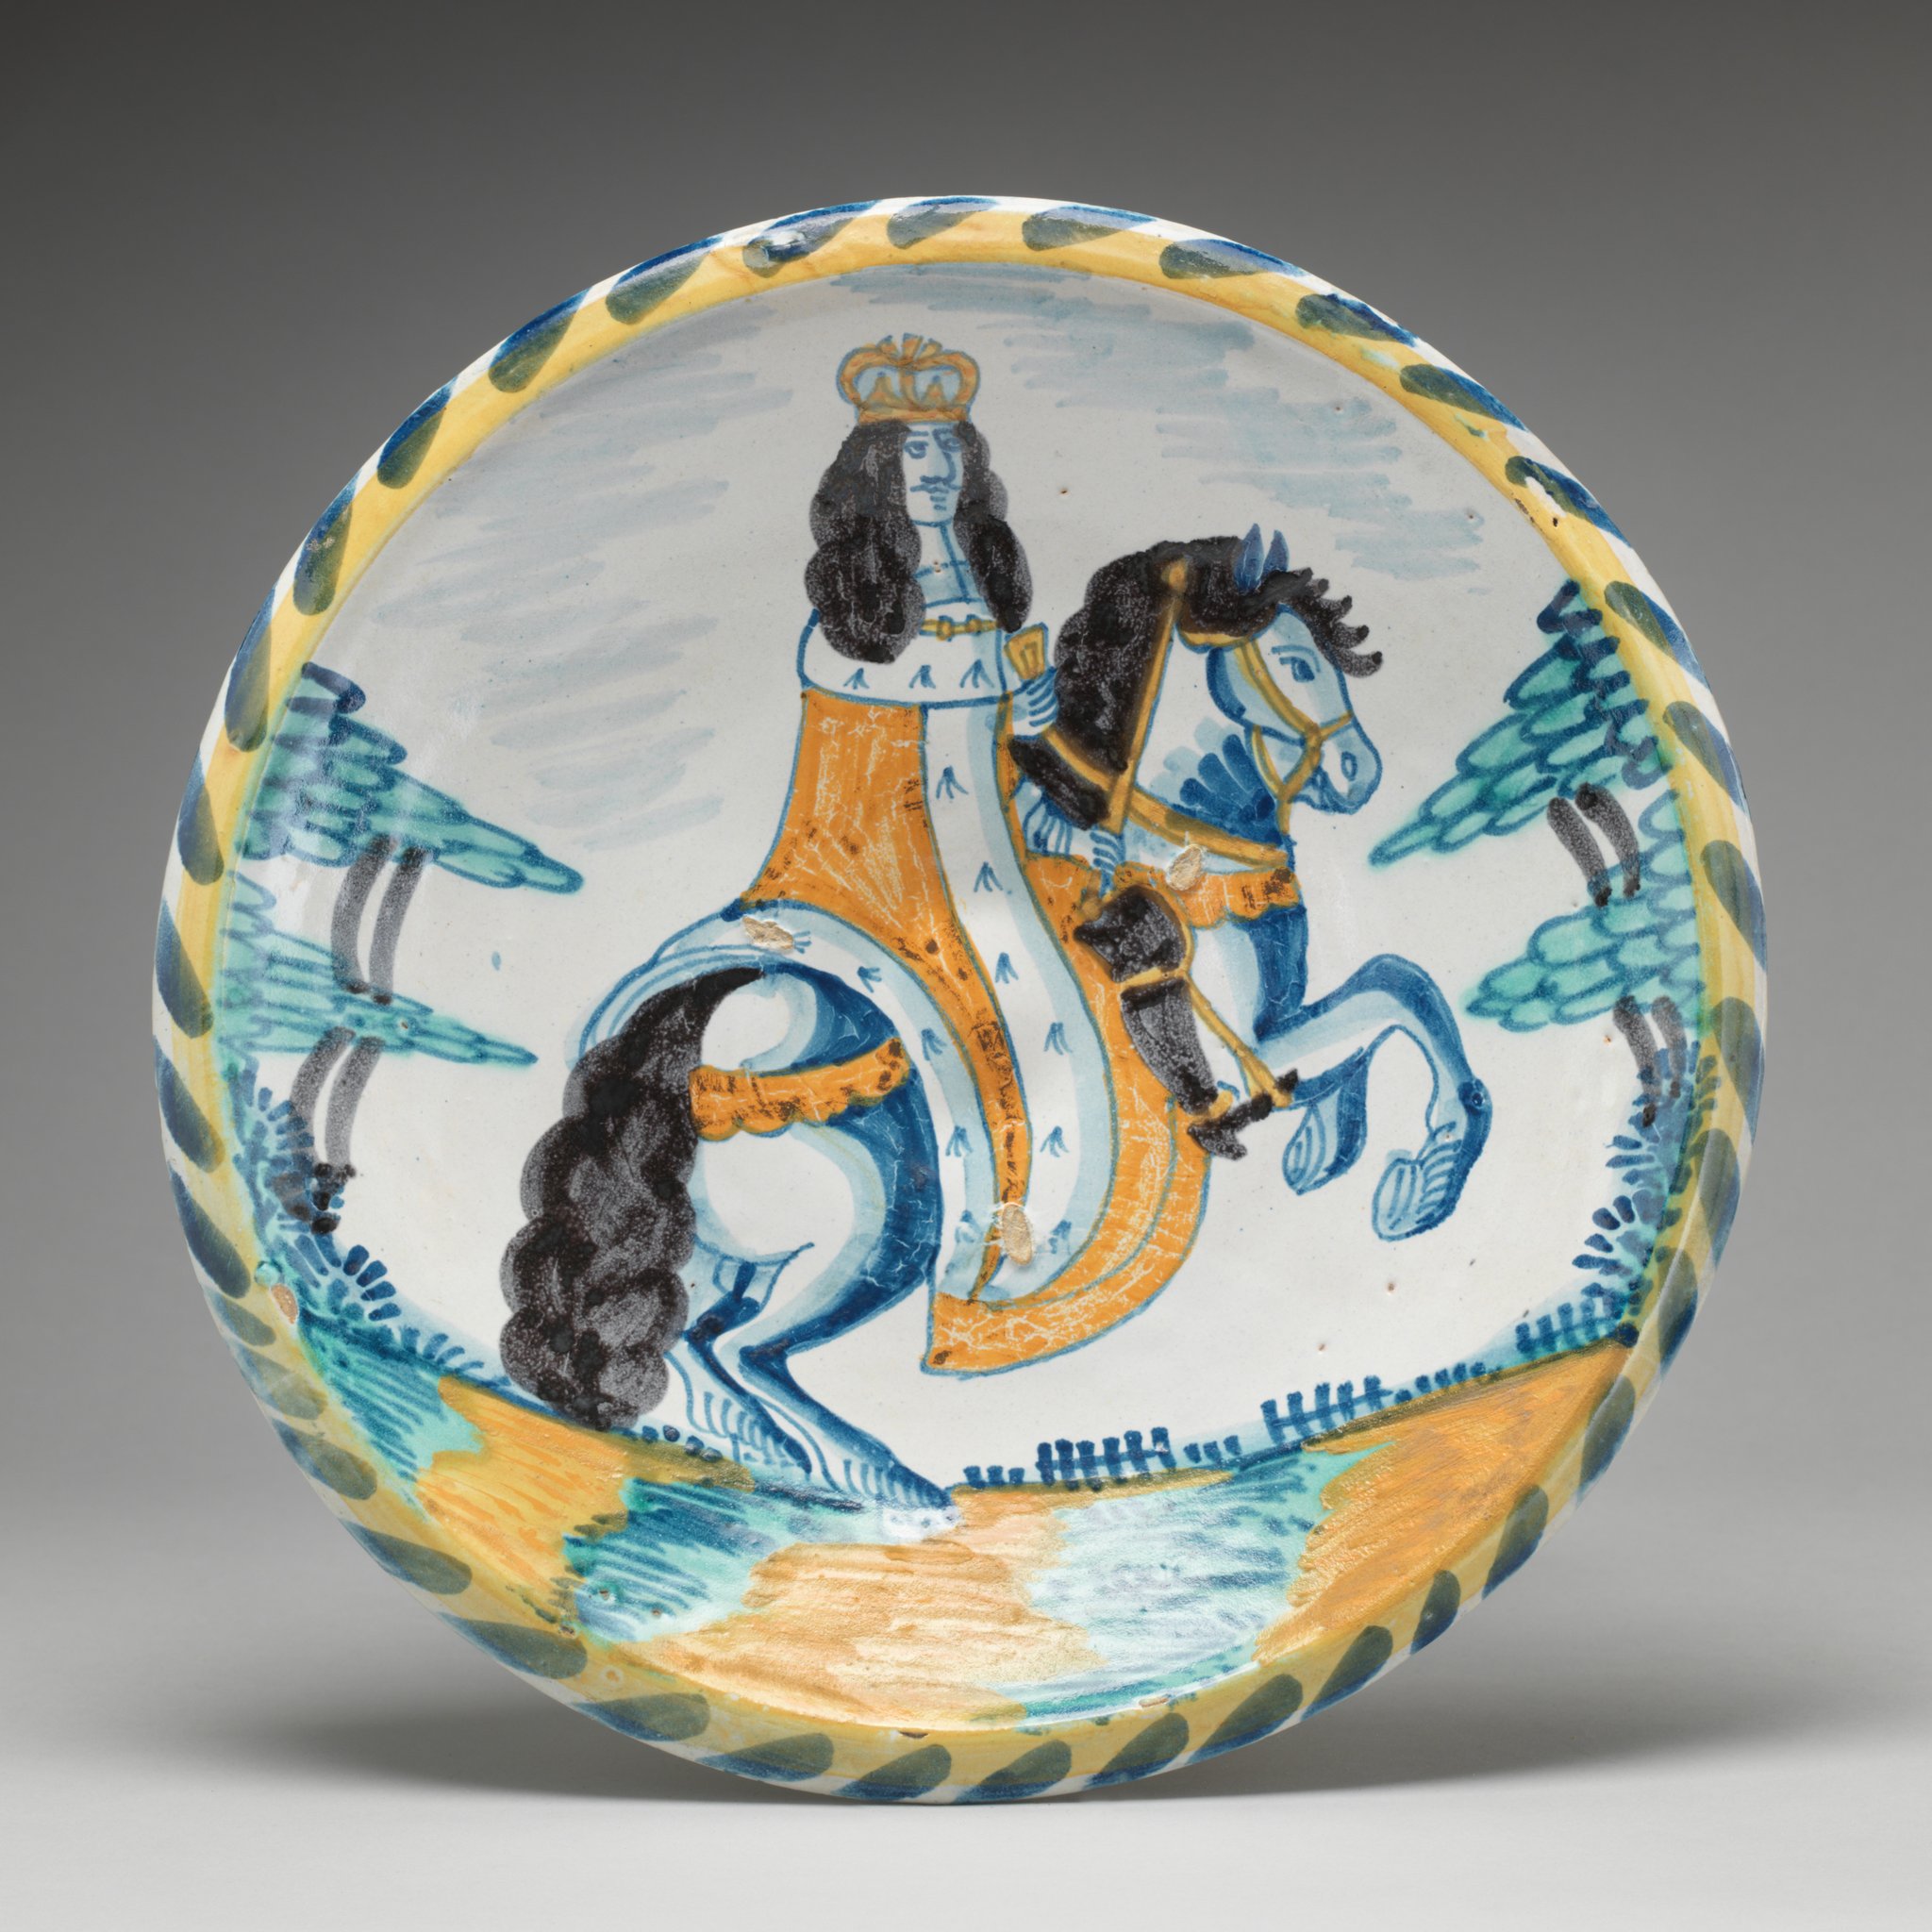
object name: dish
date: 1667-1700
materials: earthenware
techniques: glazing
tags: kings,men,horses